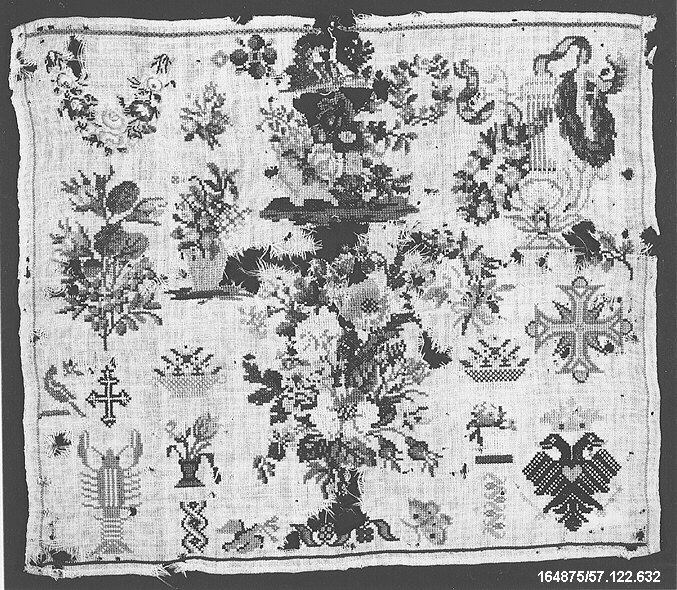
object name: sampler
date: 1801-1900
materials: canvas, silk, wool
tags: birds,butterflies,scorpions,leaves